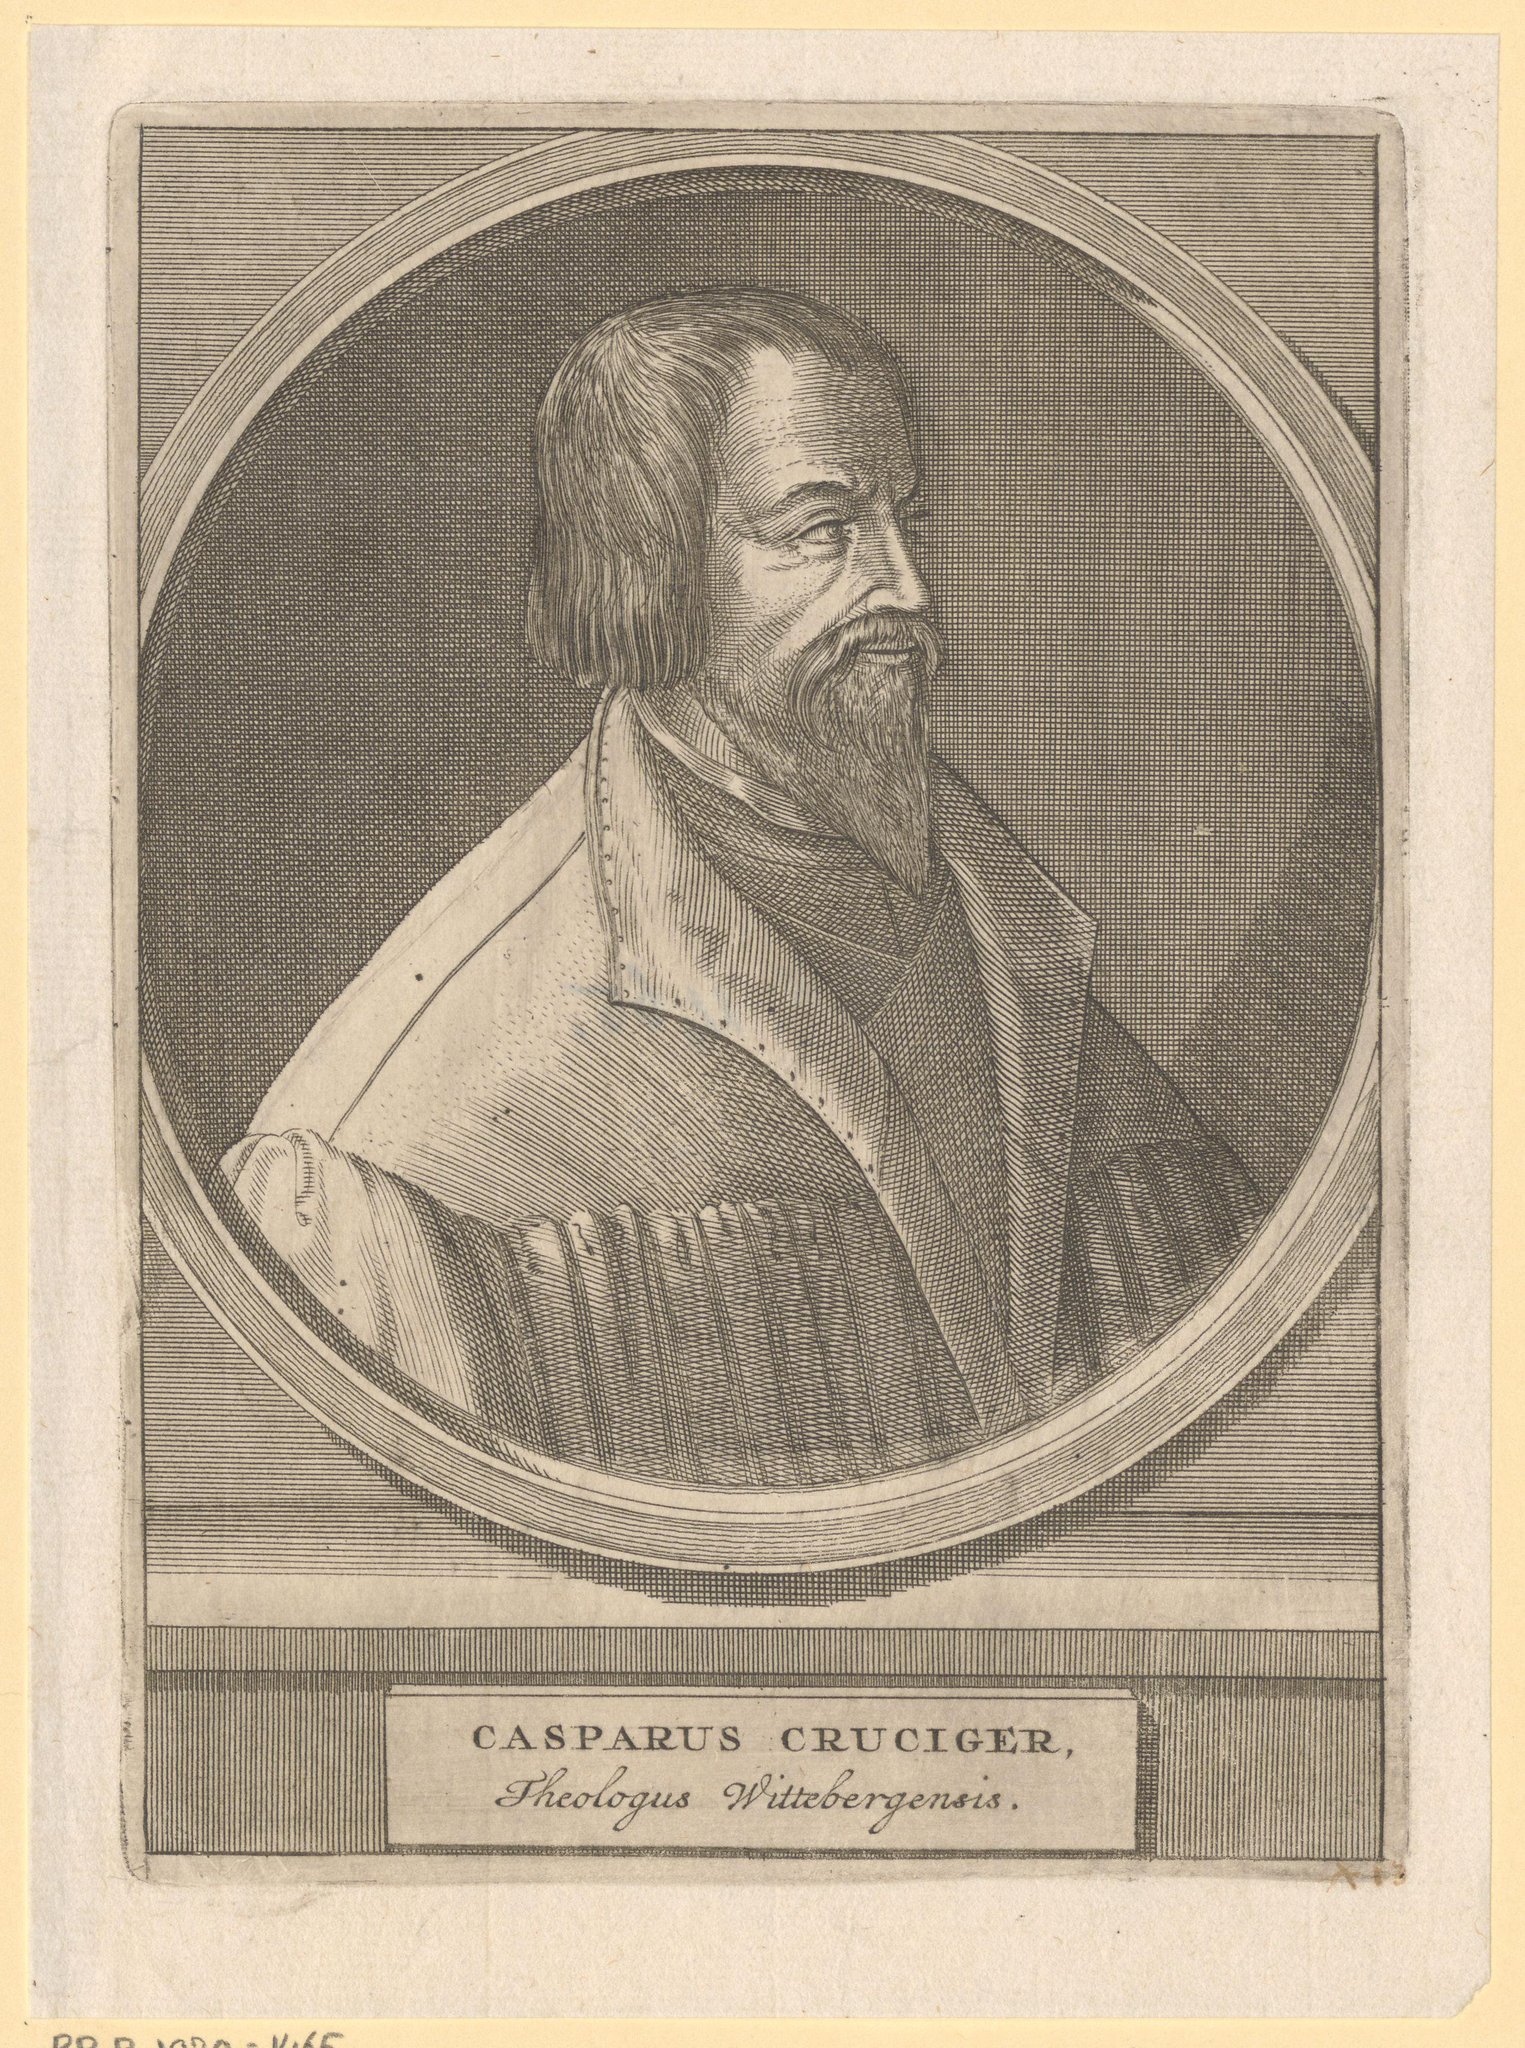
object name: print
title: Portret van Caspar Cruciger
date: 1690-1729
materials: paper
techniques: engraving, etching, intaglio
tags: historical persons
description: Prent mogelijk uit: Le miroir des portraits des premiers reformateurs des églises protestantes. Leiden: Pieter van der Aa, [1690-1729]. Eerdere staat gebruikt in serie uit 1599 en publicaties uit 1602 en 1604.